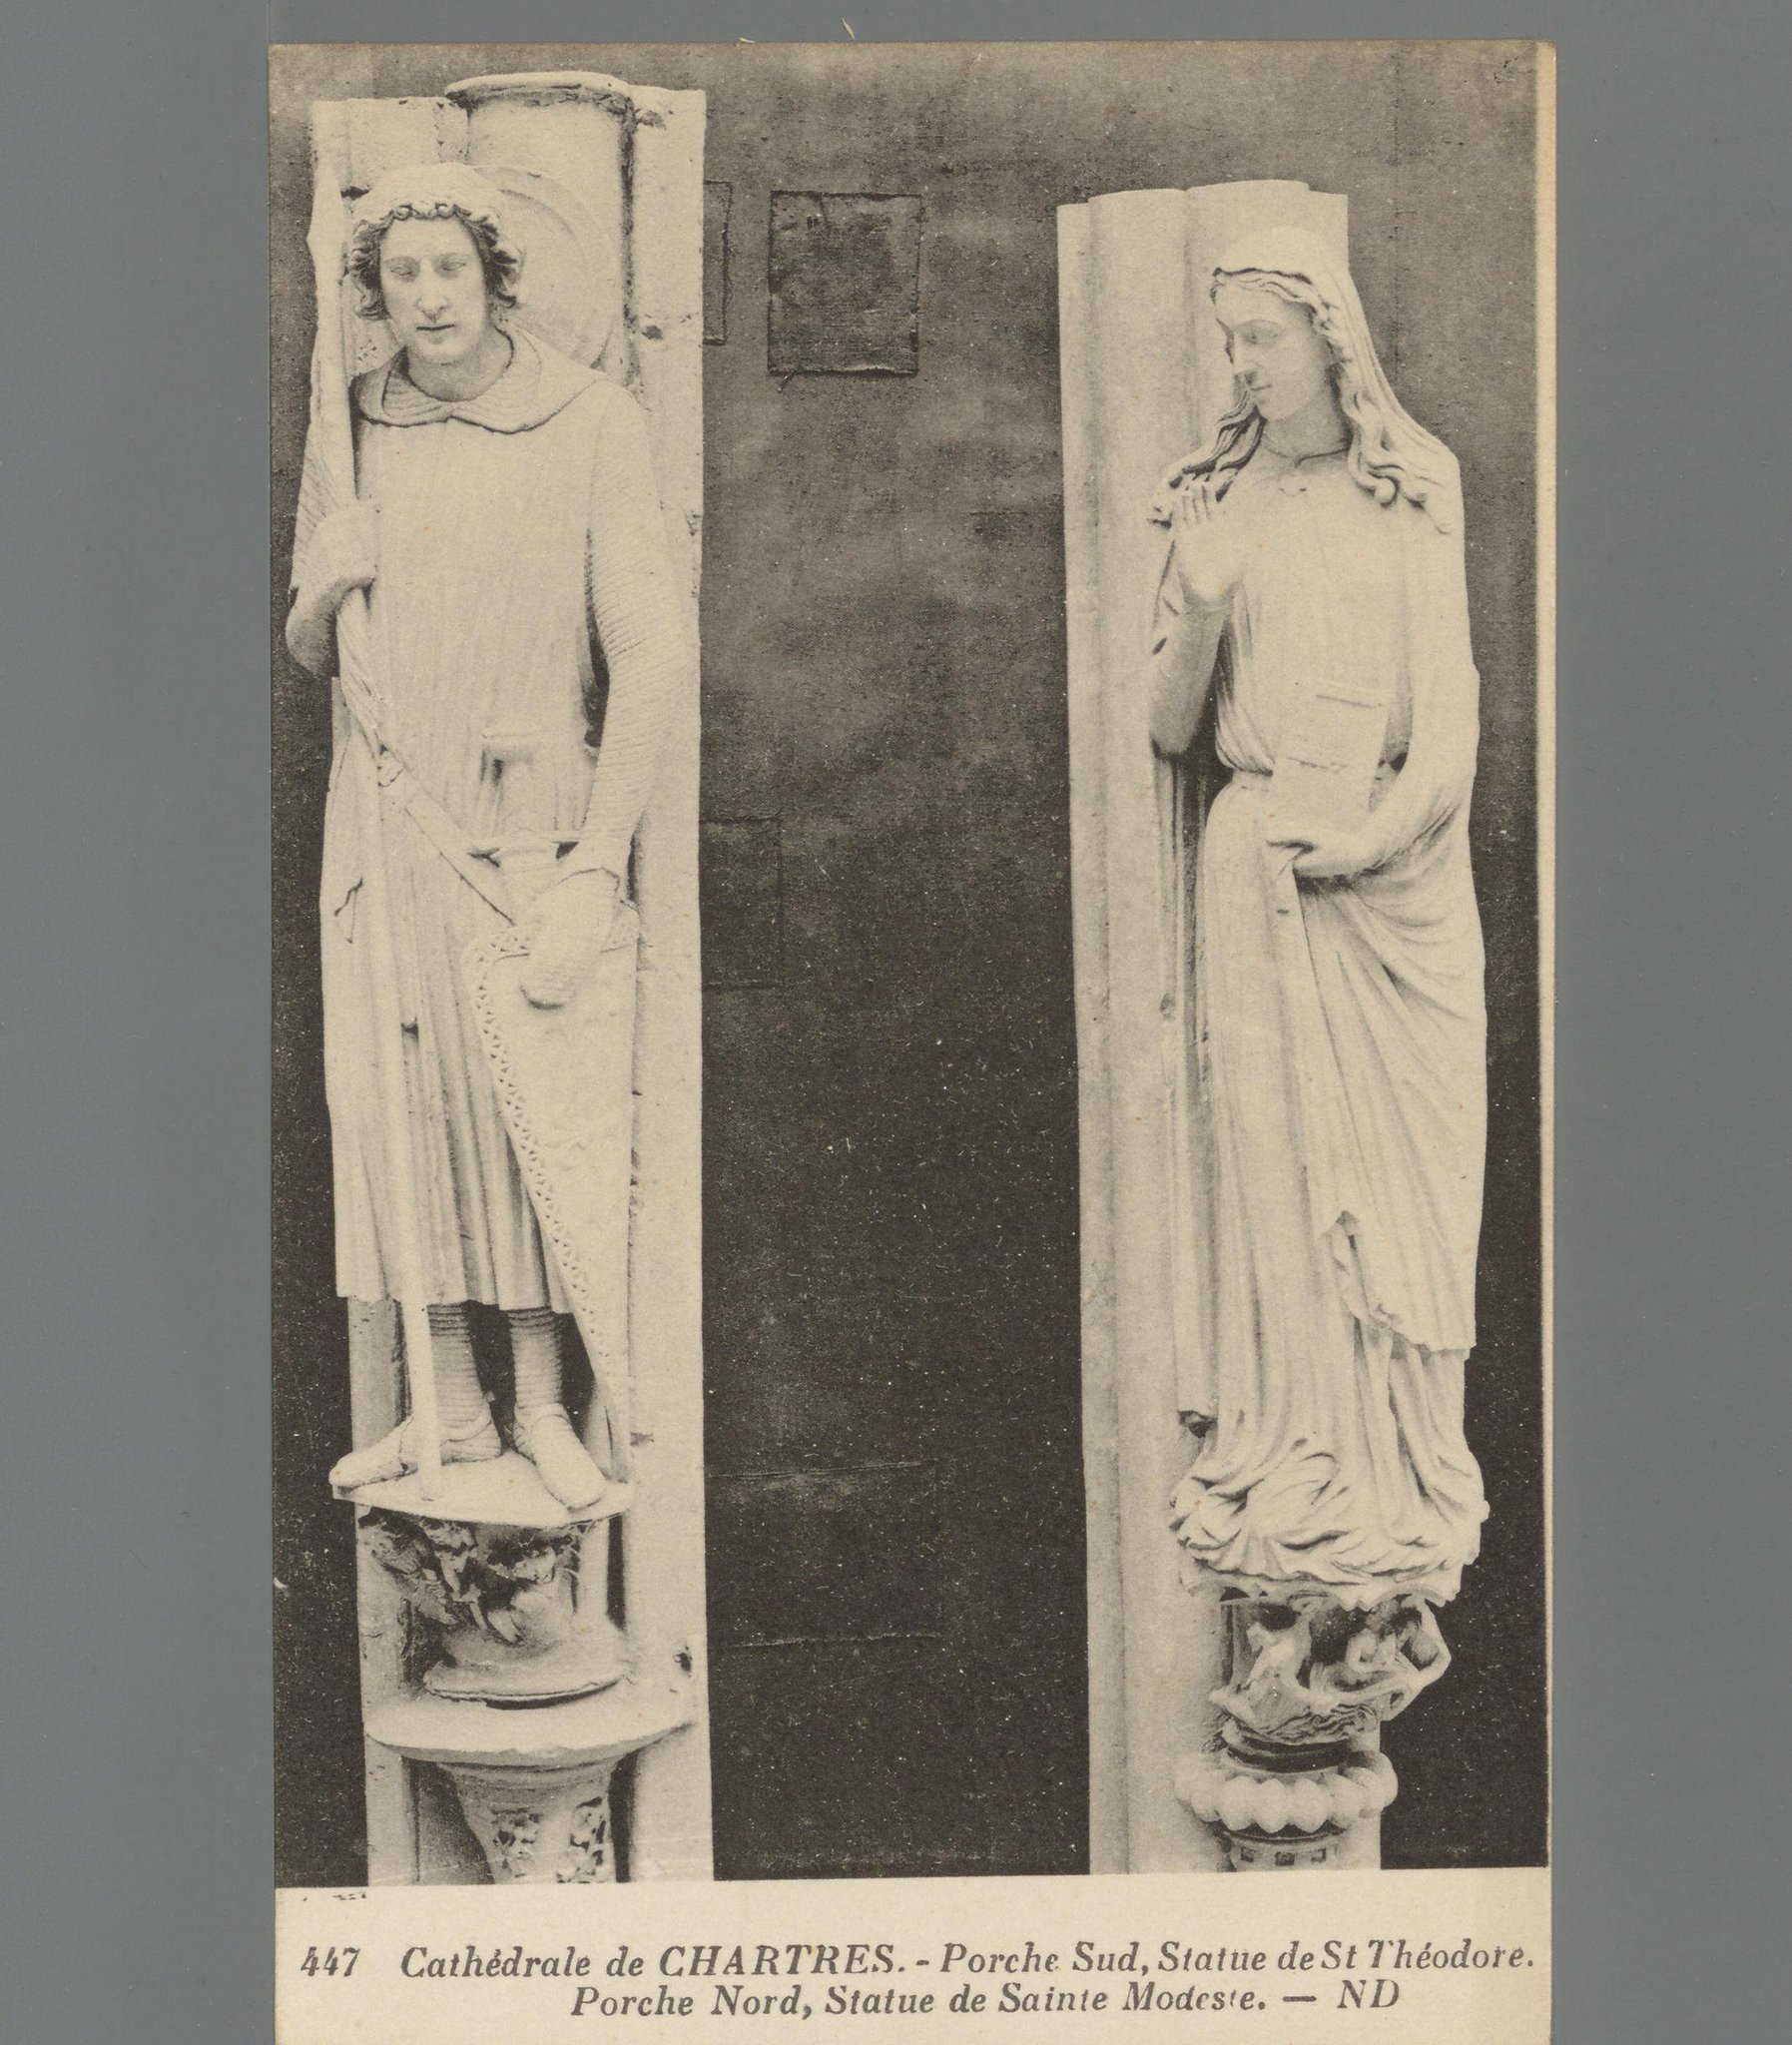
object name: ansichtkaart, prentbriefkaart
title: Cathédrale de Chartres. Porche Sud, statue de St. Théodore. Porche Nord, statue de sainte modeste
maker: Anonymous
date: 1903-1932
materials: cardboard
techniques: photograph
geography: paris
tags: church (exterior), statues, paintings, etc. ~ objects of worship in roman religion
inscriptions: collector's mark: ‘AFE v S’